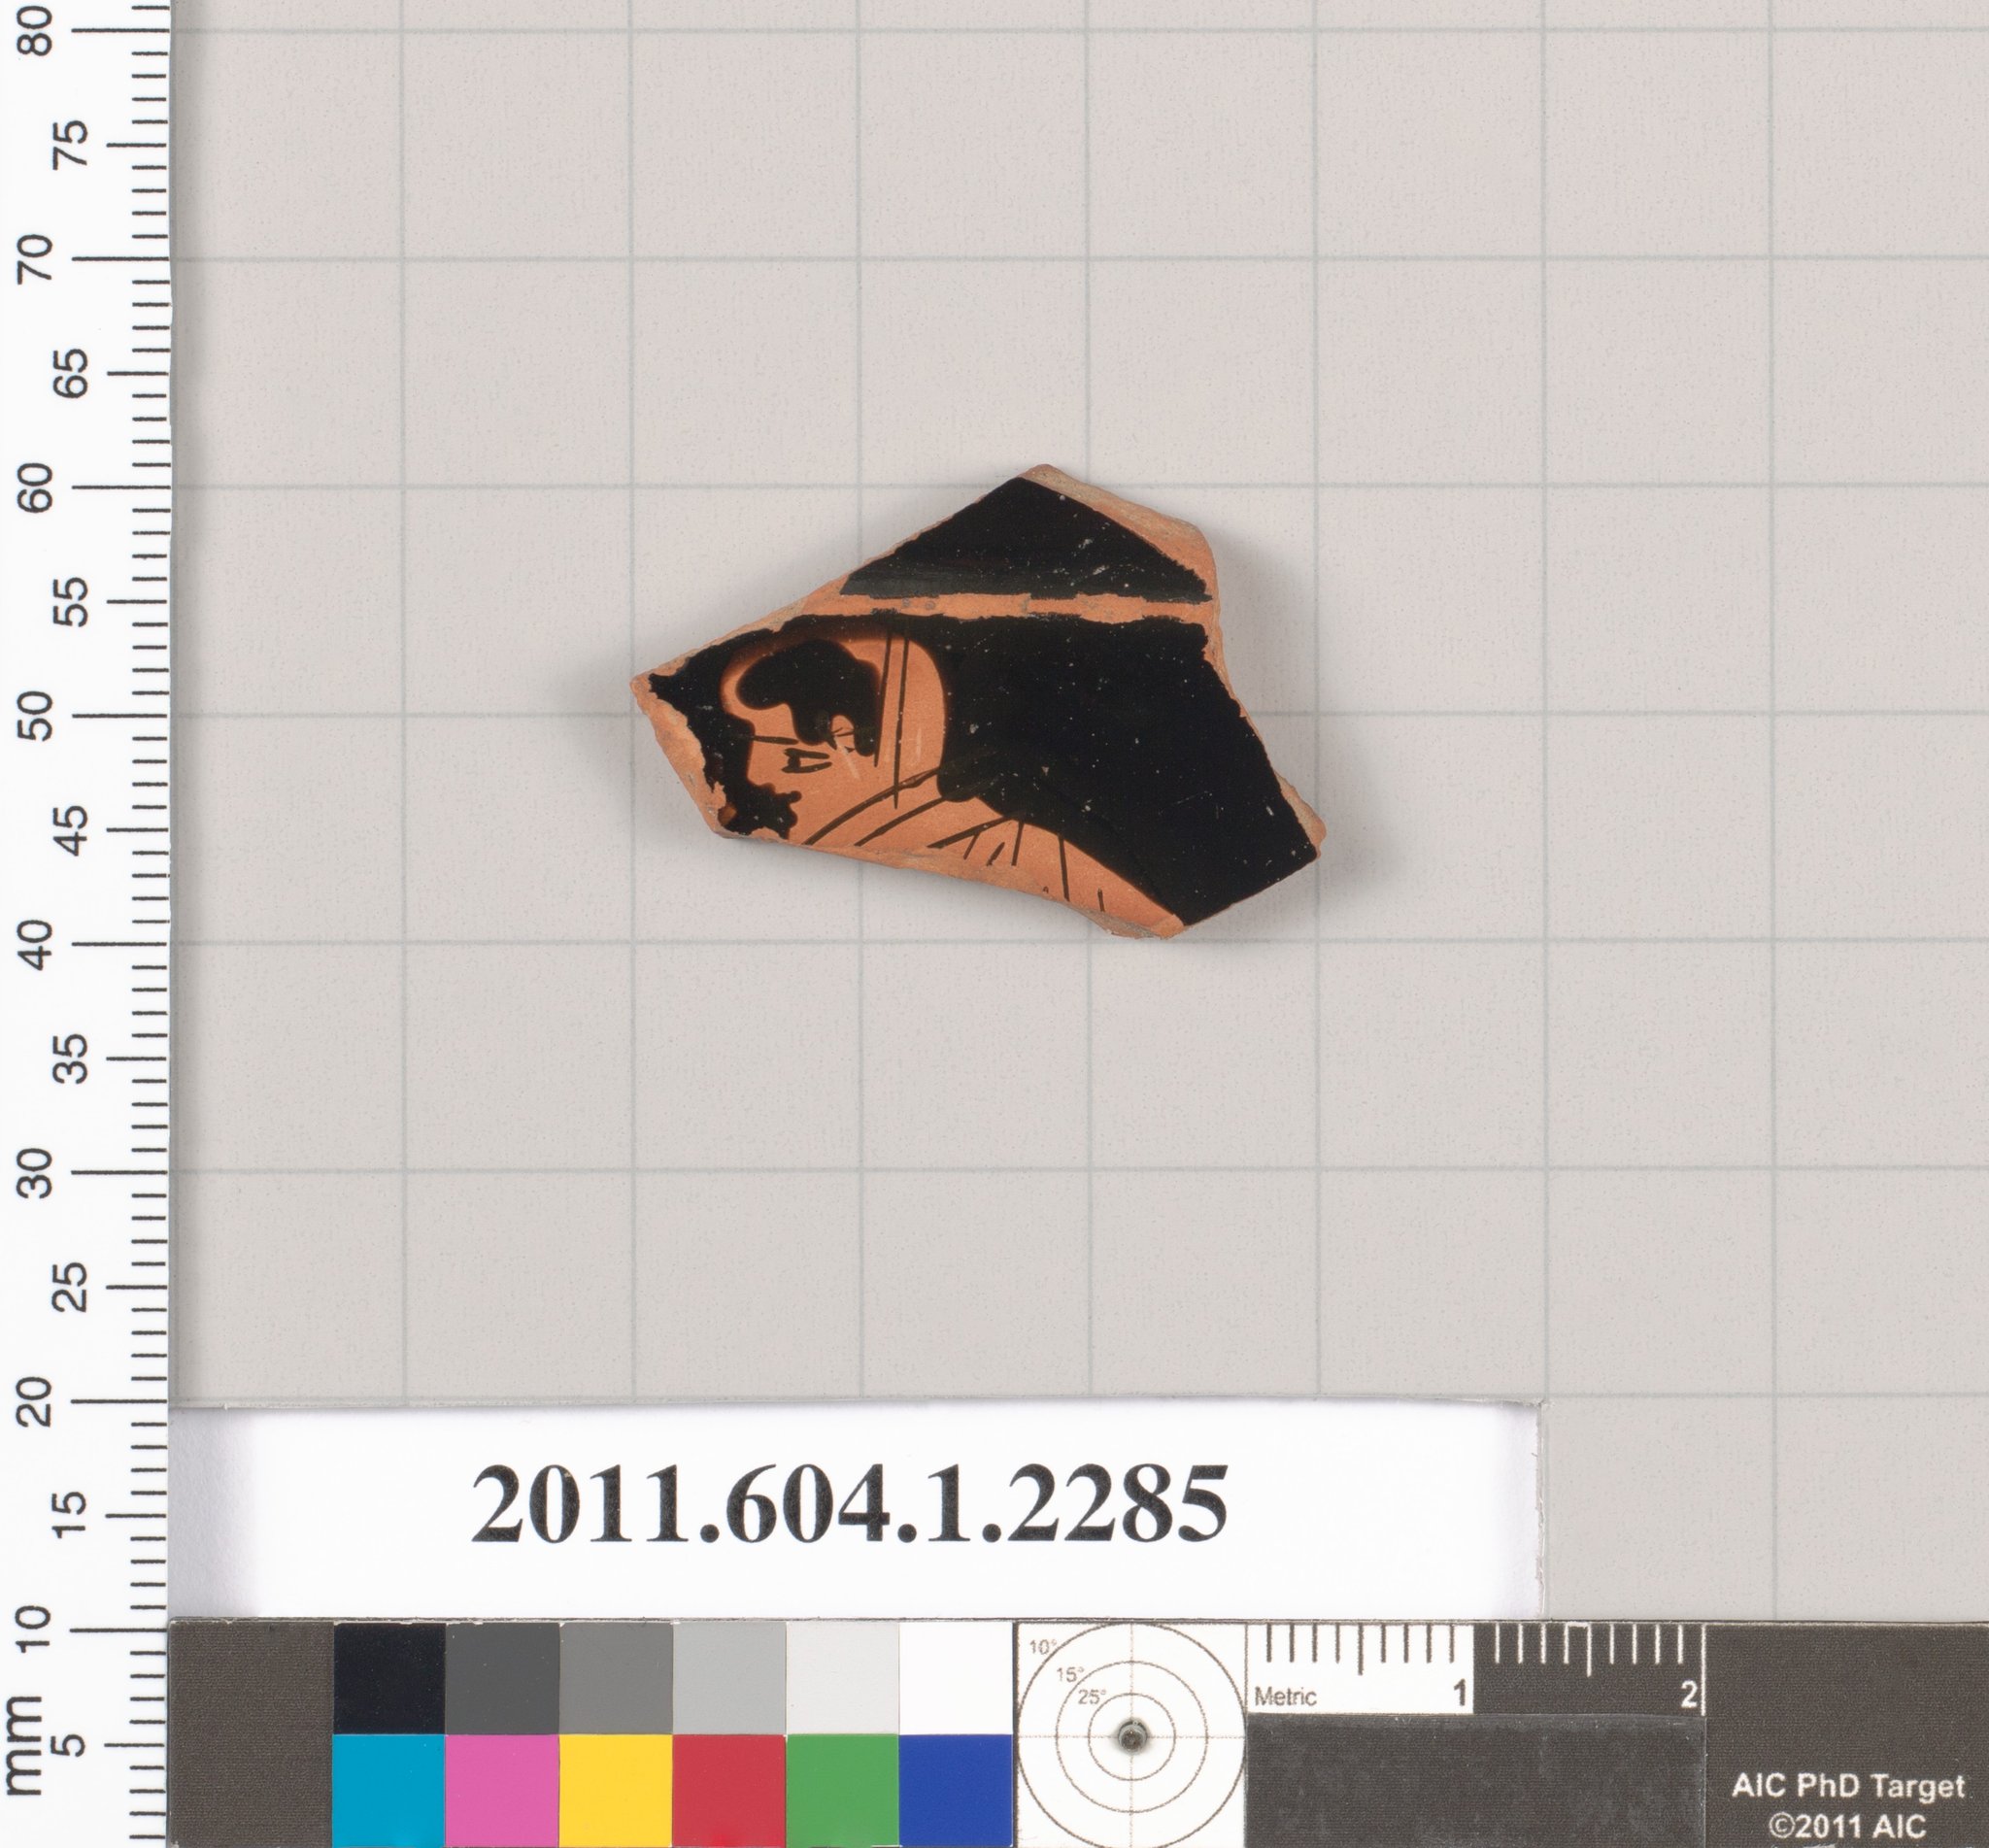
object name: kylix fragment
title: Terracotta fragment of a kylix (drinking cup)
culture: greek, attic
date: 450-426 BCE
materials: terracotta